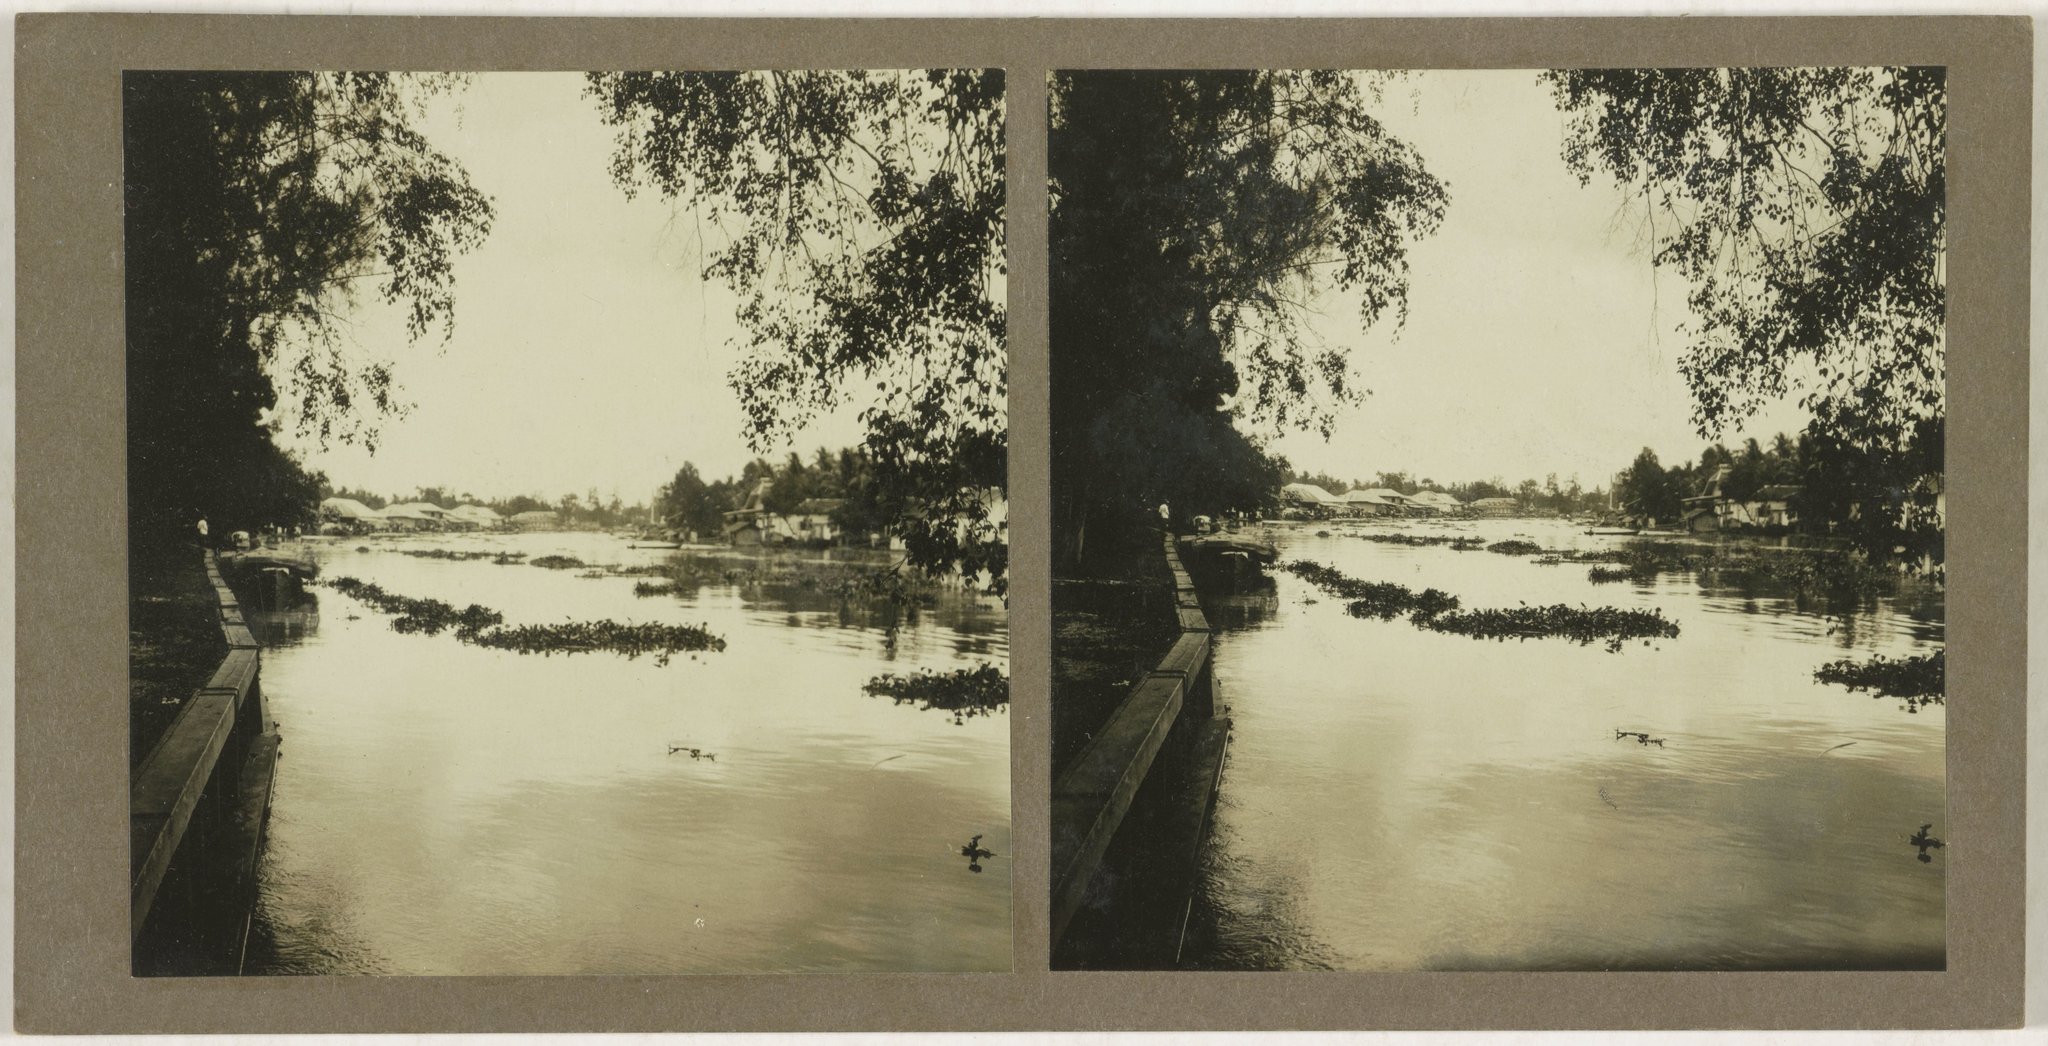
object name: stereograph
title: Gezicht op vermoedelijke de Sungai Negara op Borneo, Indonesië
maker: Anonymous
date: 1900-1940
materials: paper, cardboard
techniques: gelatin silver print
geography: indonesia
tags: river, indonesia